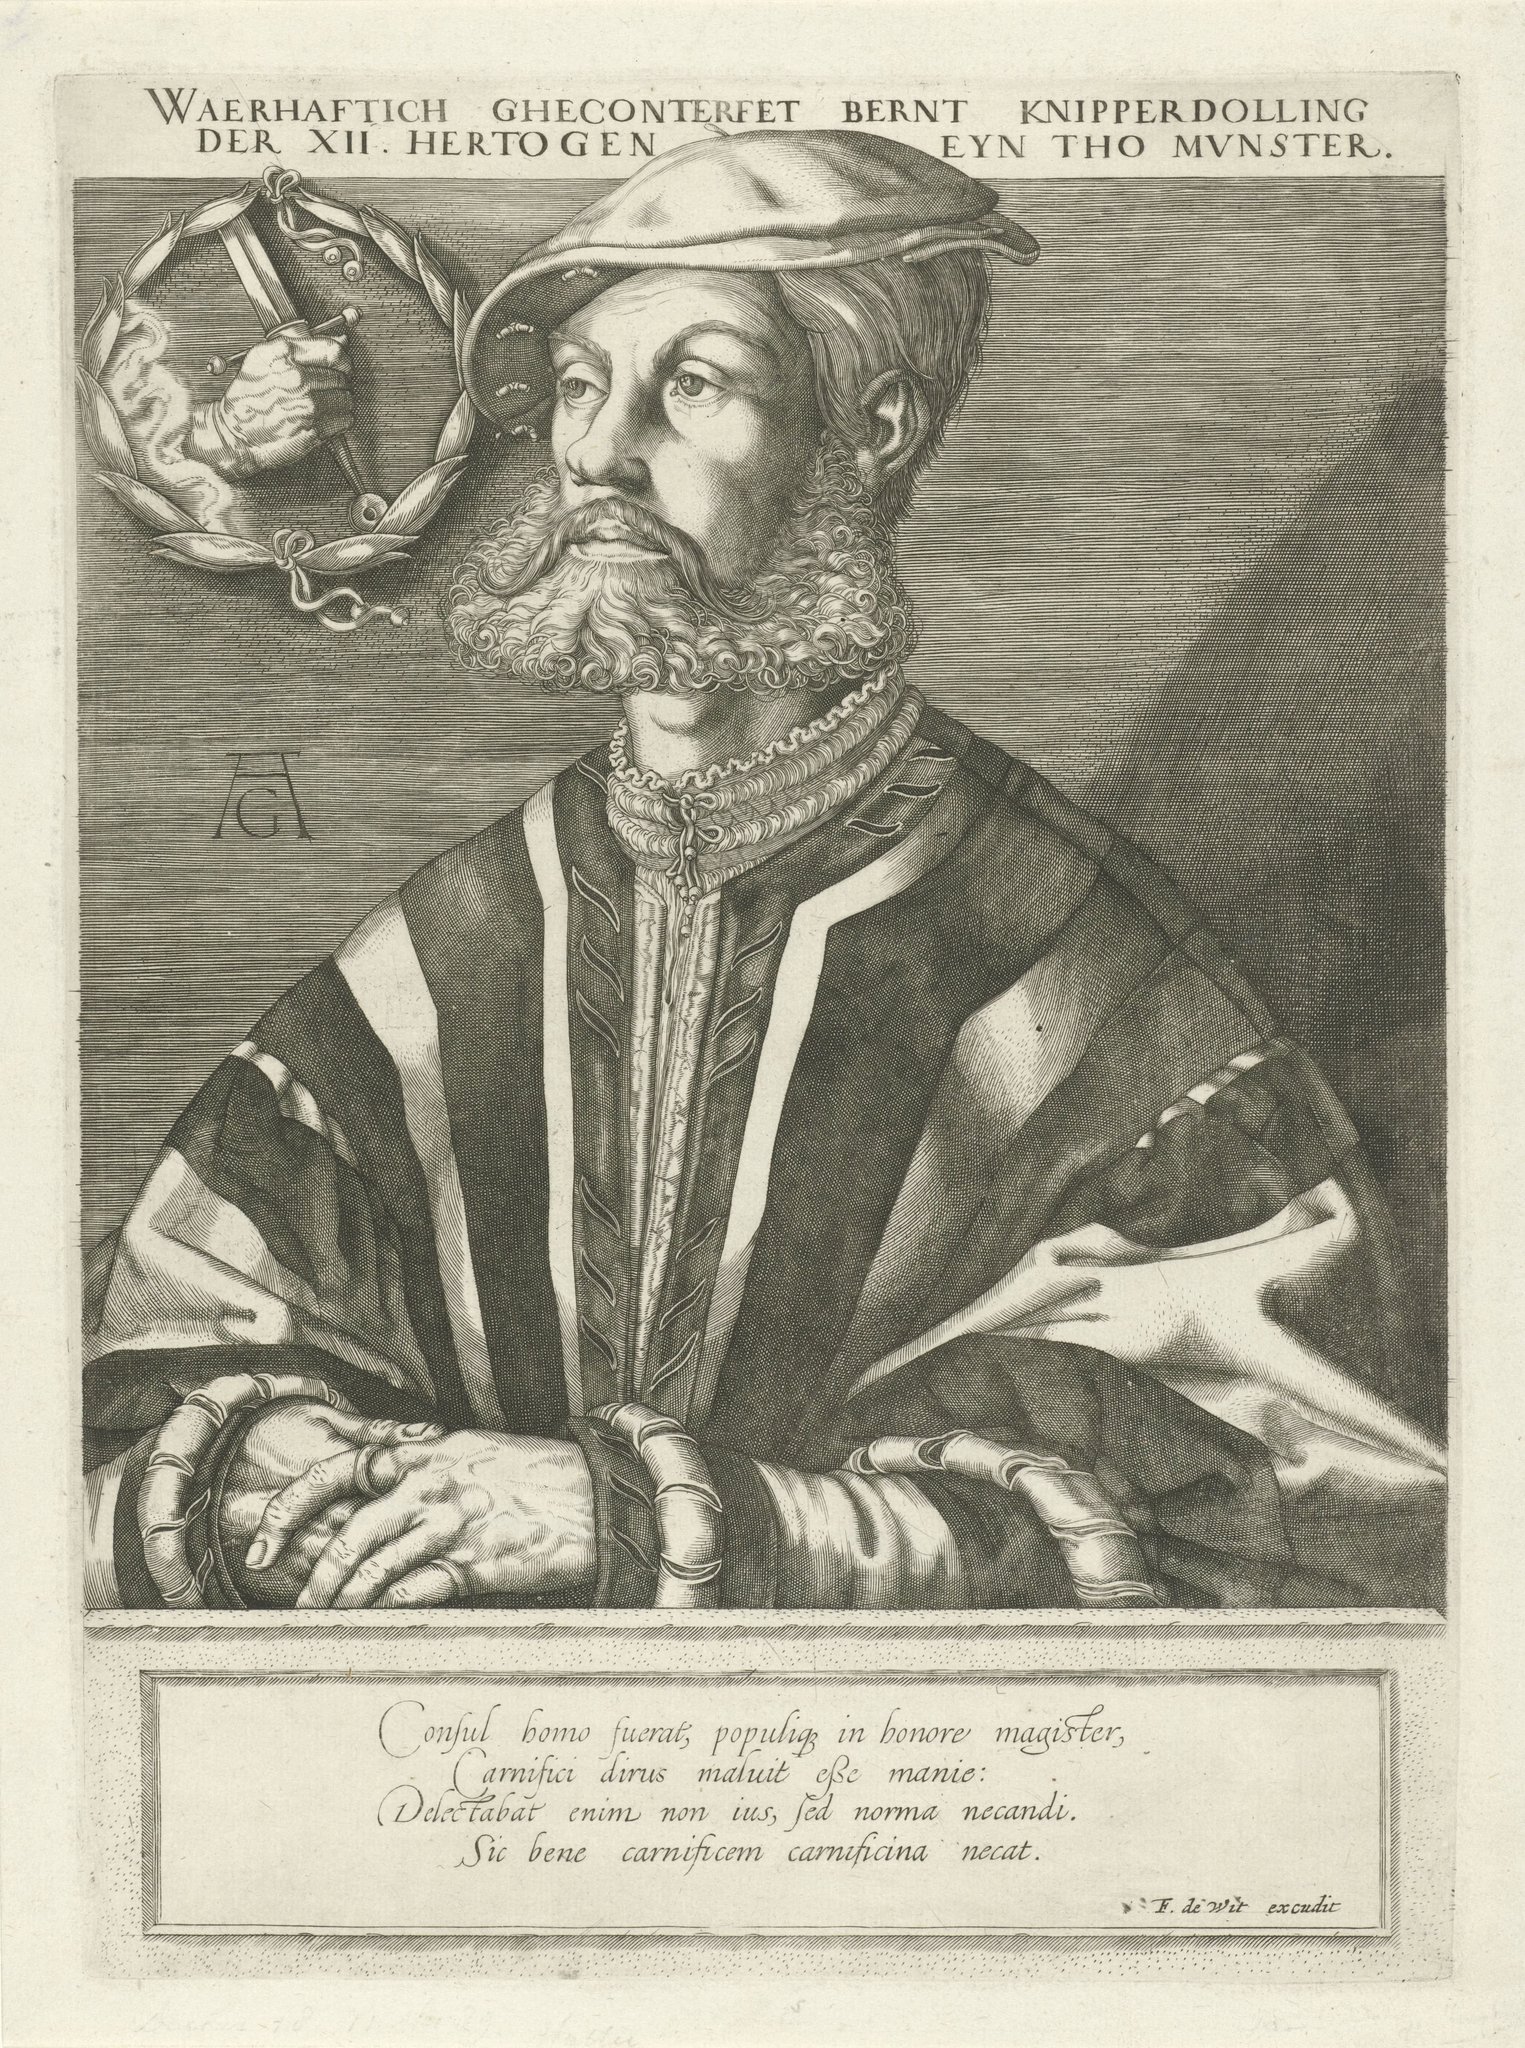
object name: print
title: Portret van Bernardus Knipperdolling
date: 1613-1617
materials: paper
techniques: engraving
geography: amsterdam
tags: hacking and thrusting weapons: sword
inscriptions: collector's mark: Lugt 2228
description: Portret van Bernardus Knipperdolling, leider van de wederdopers in Münster. Linksboven een lauwerkrans met daarin een hand met een zwaard. Onderaan een vierregelig vers in het Latijn.